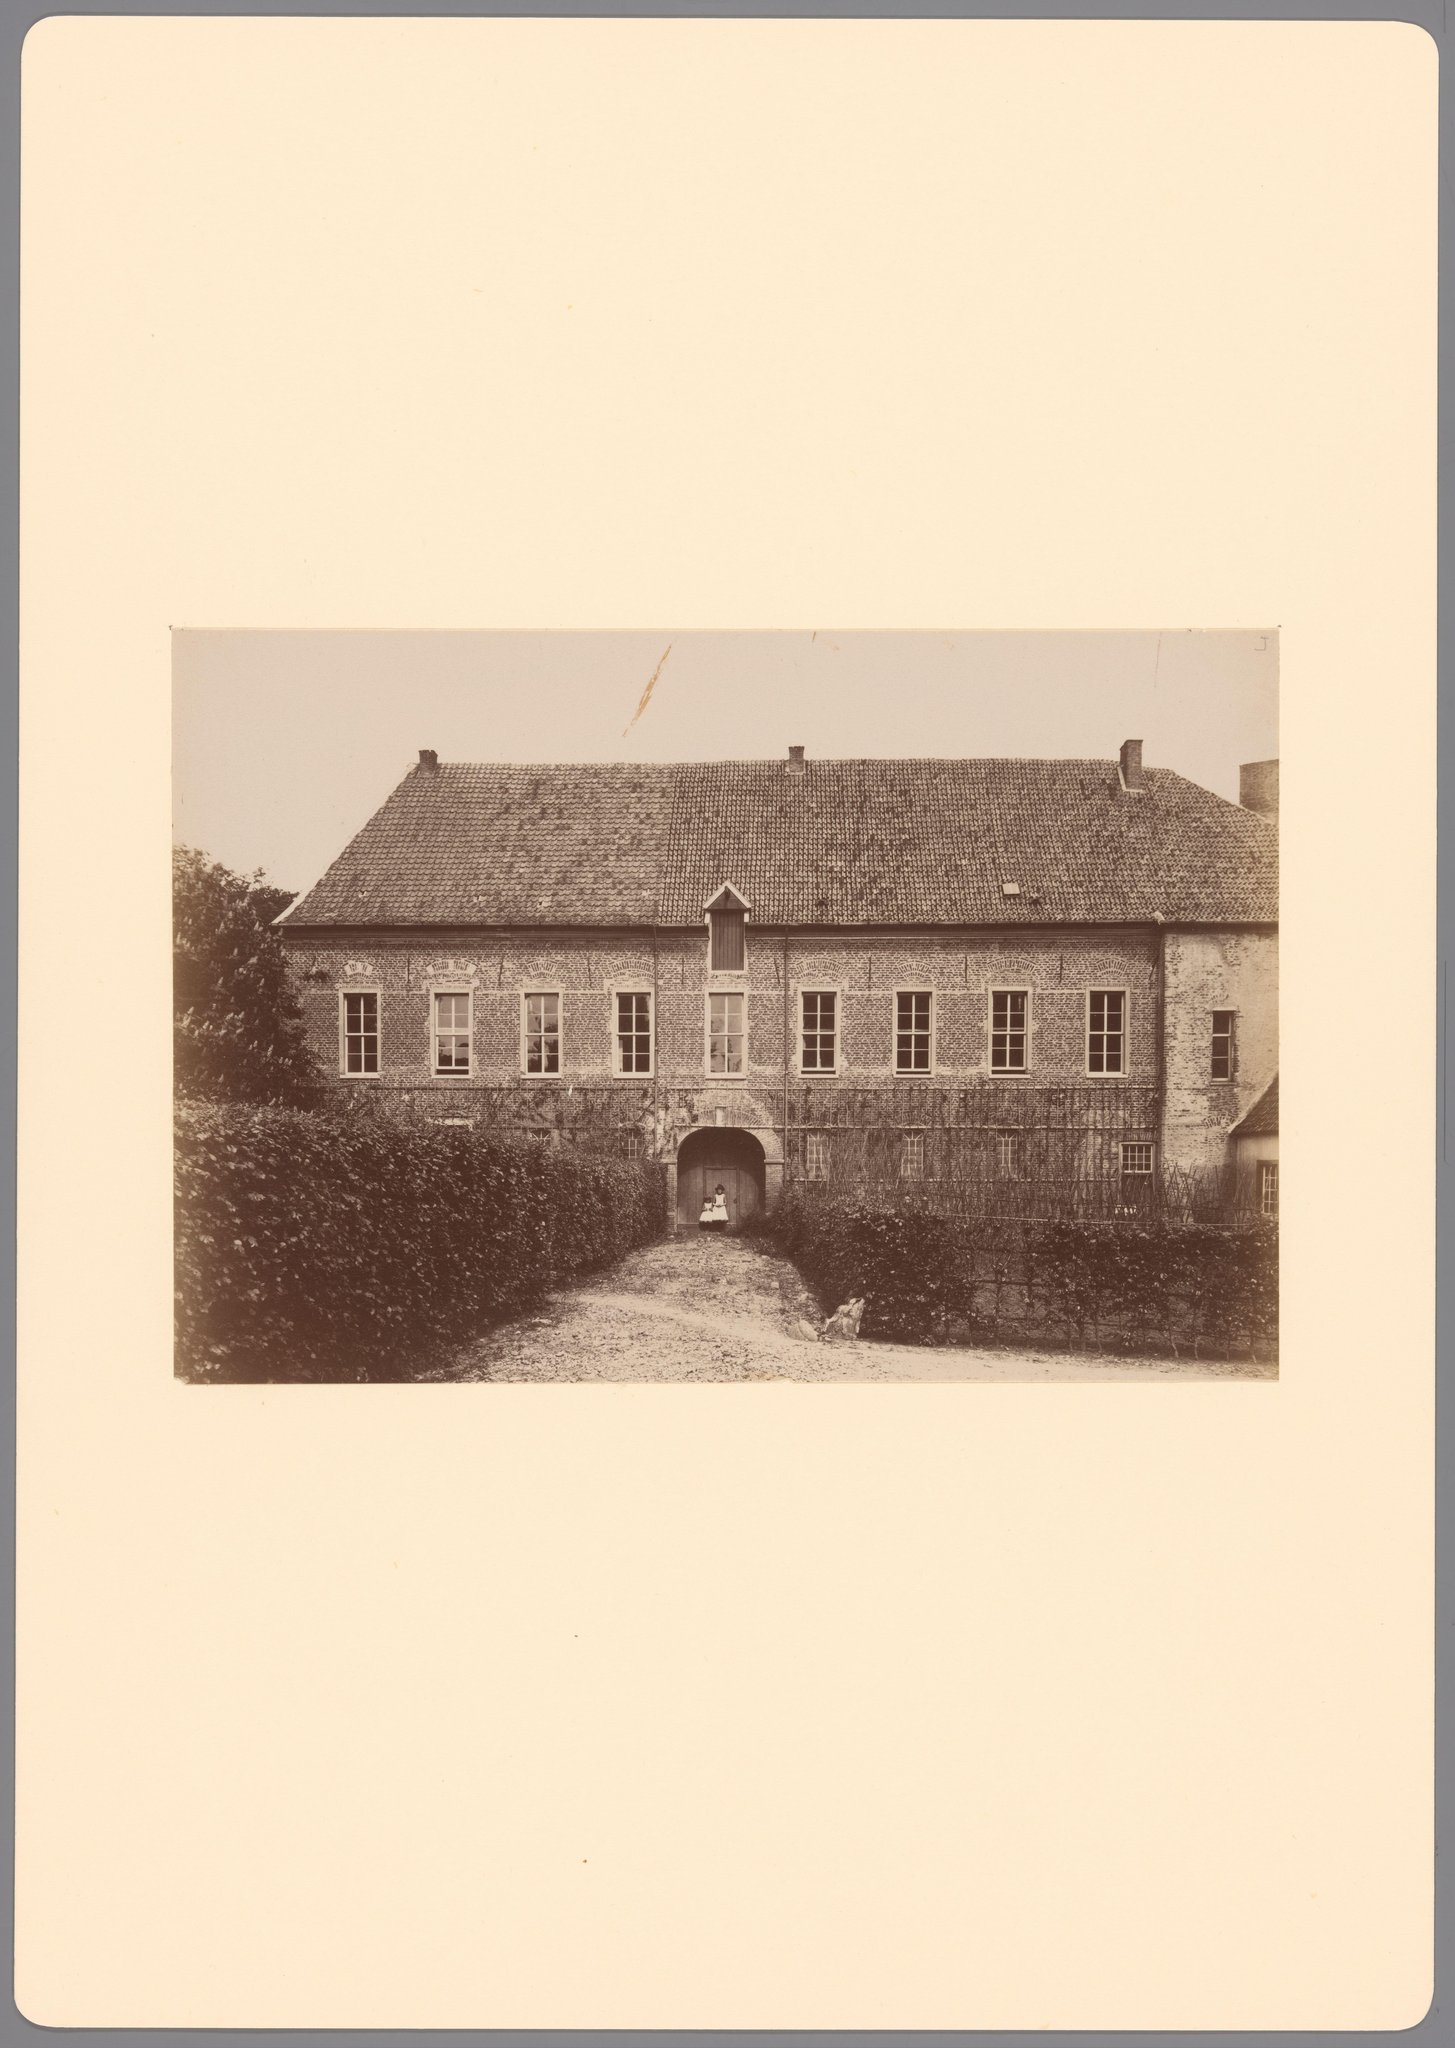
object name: photograph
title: Gedeelte van het Huis Bergh te 's Heerenberg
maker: anoniem (monumentenzorg)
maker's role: fotograaf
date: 1890-1920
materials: cardboard, photographic support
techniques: albumen print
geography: s-heerenberg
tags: castle, landscape with tower or castle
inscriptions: annotation: ‘Kasteel te 's Heerenberg/ schouw gebouw’